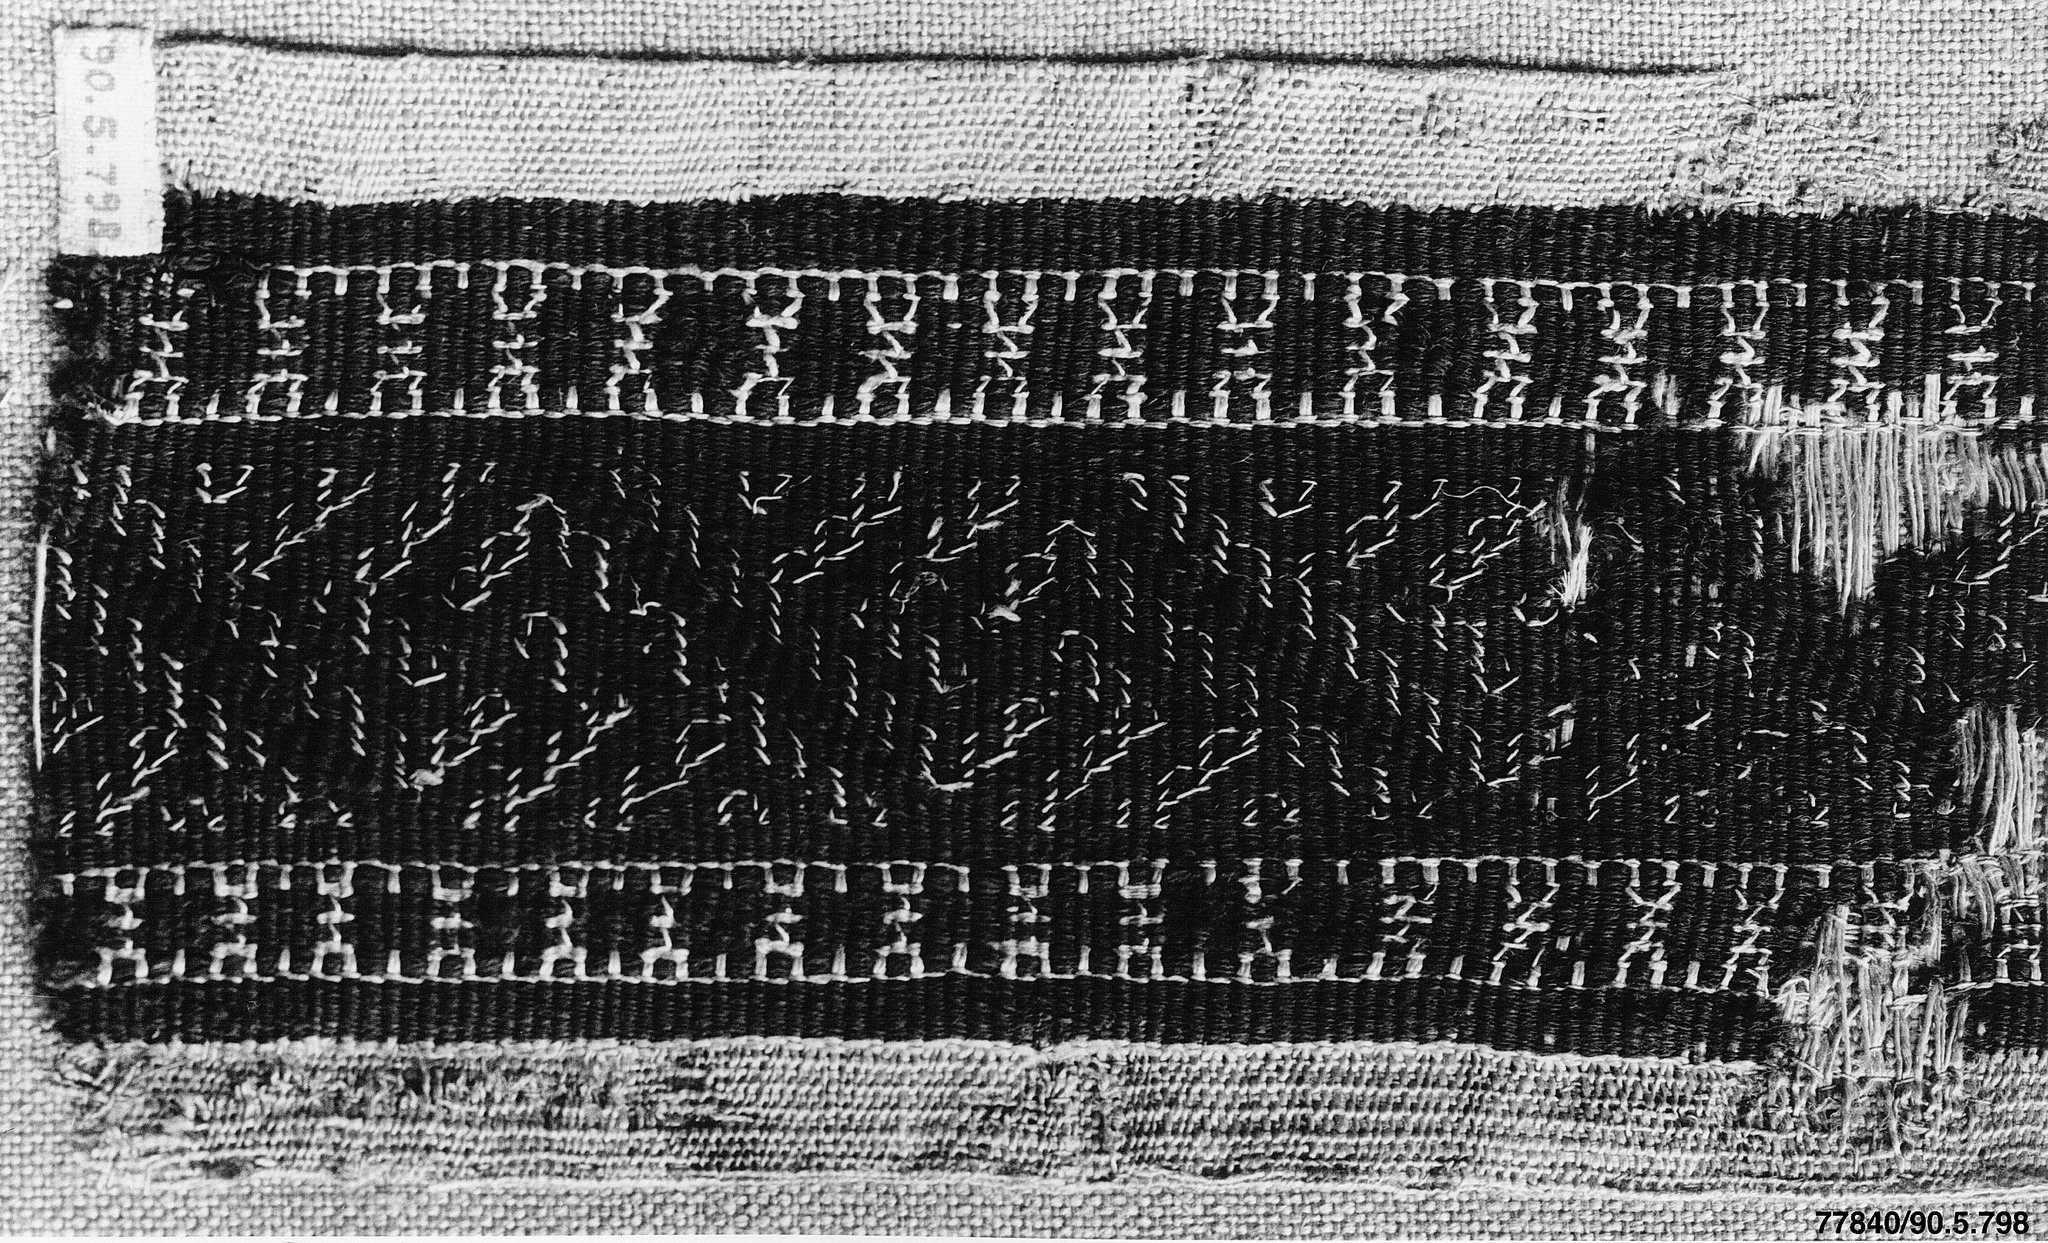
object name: textile fragment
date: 201-400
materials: linen, wool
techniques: weave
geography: egypt